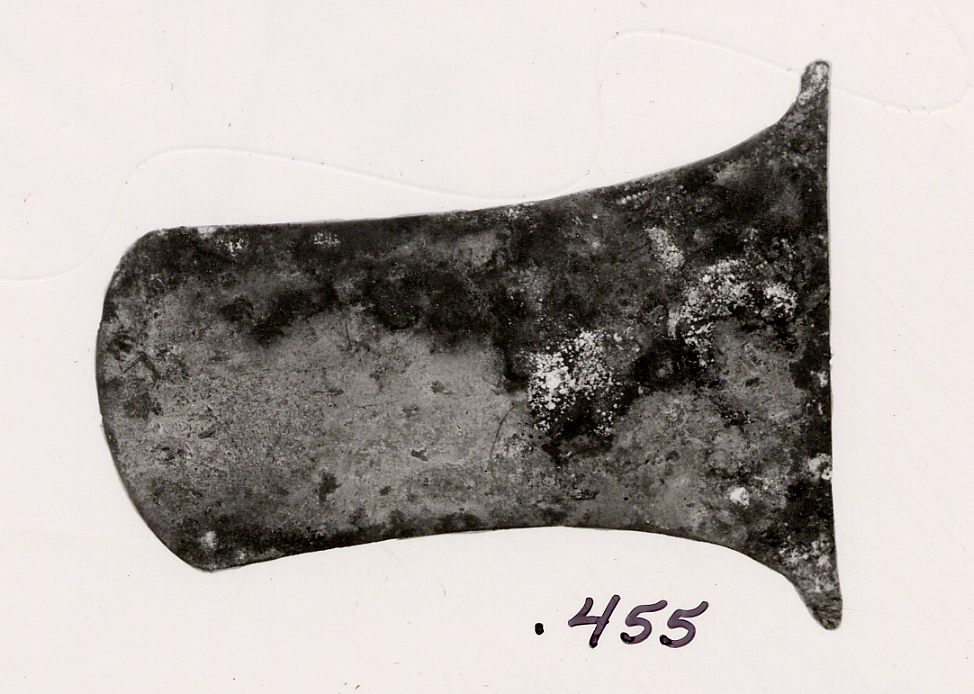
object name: ax blade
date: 1550-1458 BCE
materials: copper alloy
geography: egypt